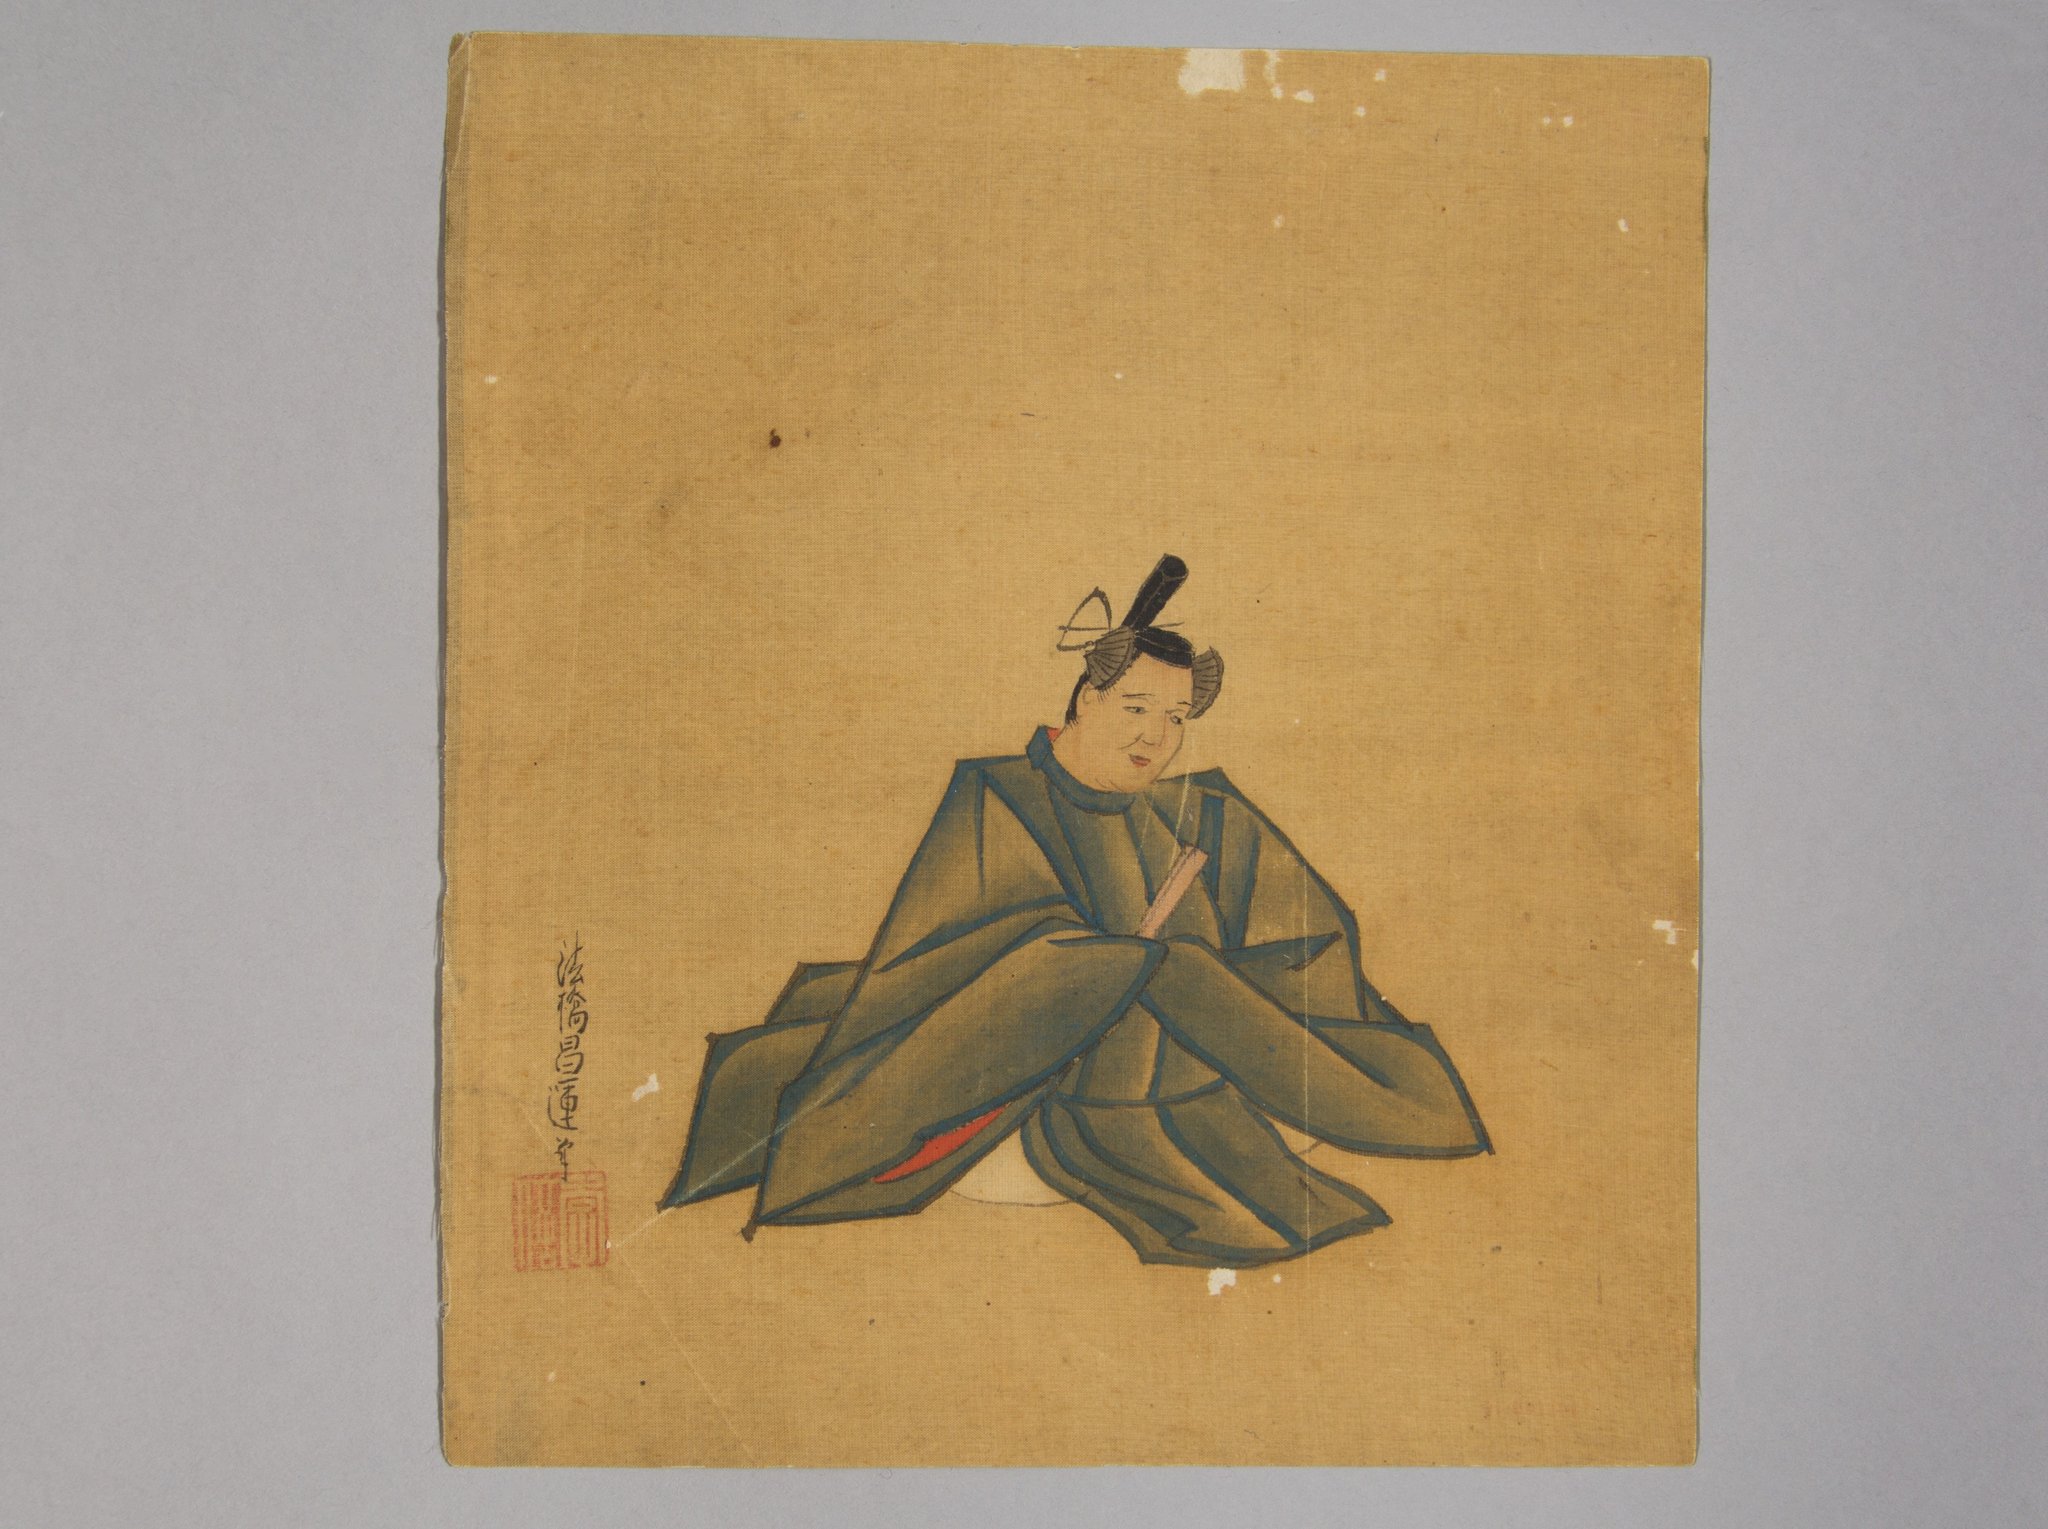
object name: painting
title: Immortal Poet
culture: japanese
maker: kano shōun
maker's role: artist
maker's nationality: japanese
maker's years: 1637-1702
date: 1601-1700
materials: ink, silk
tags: men,poets